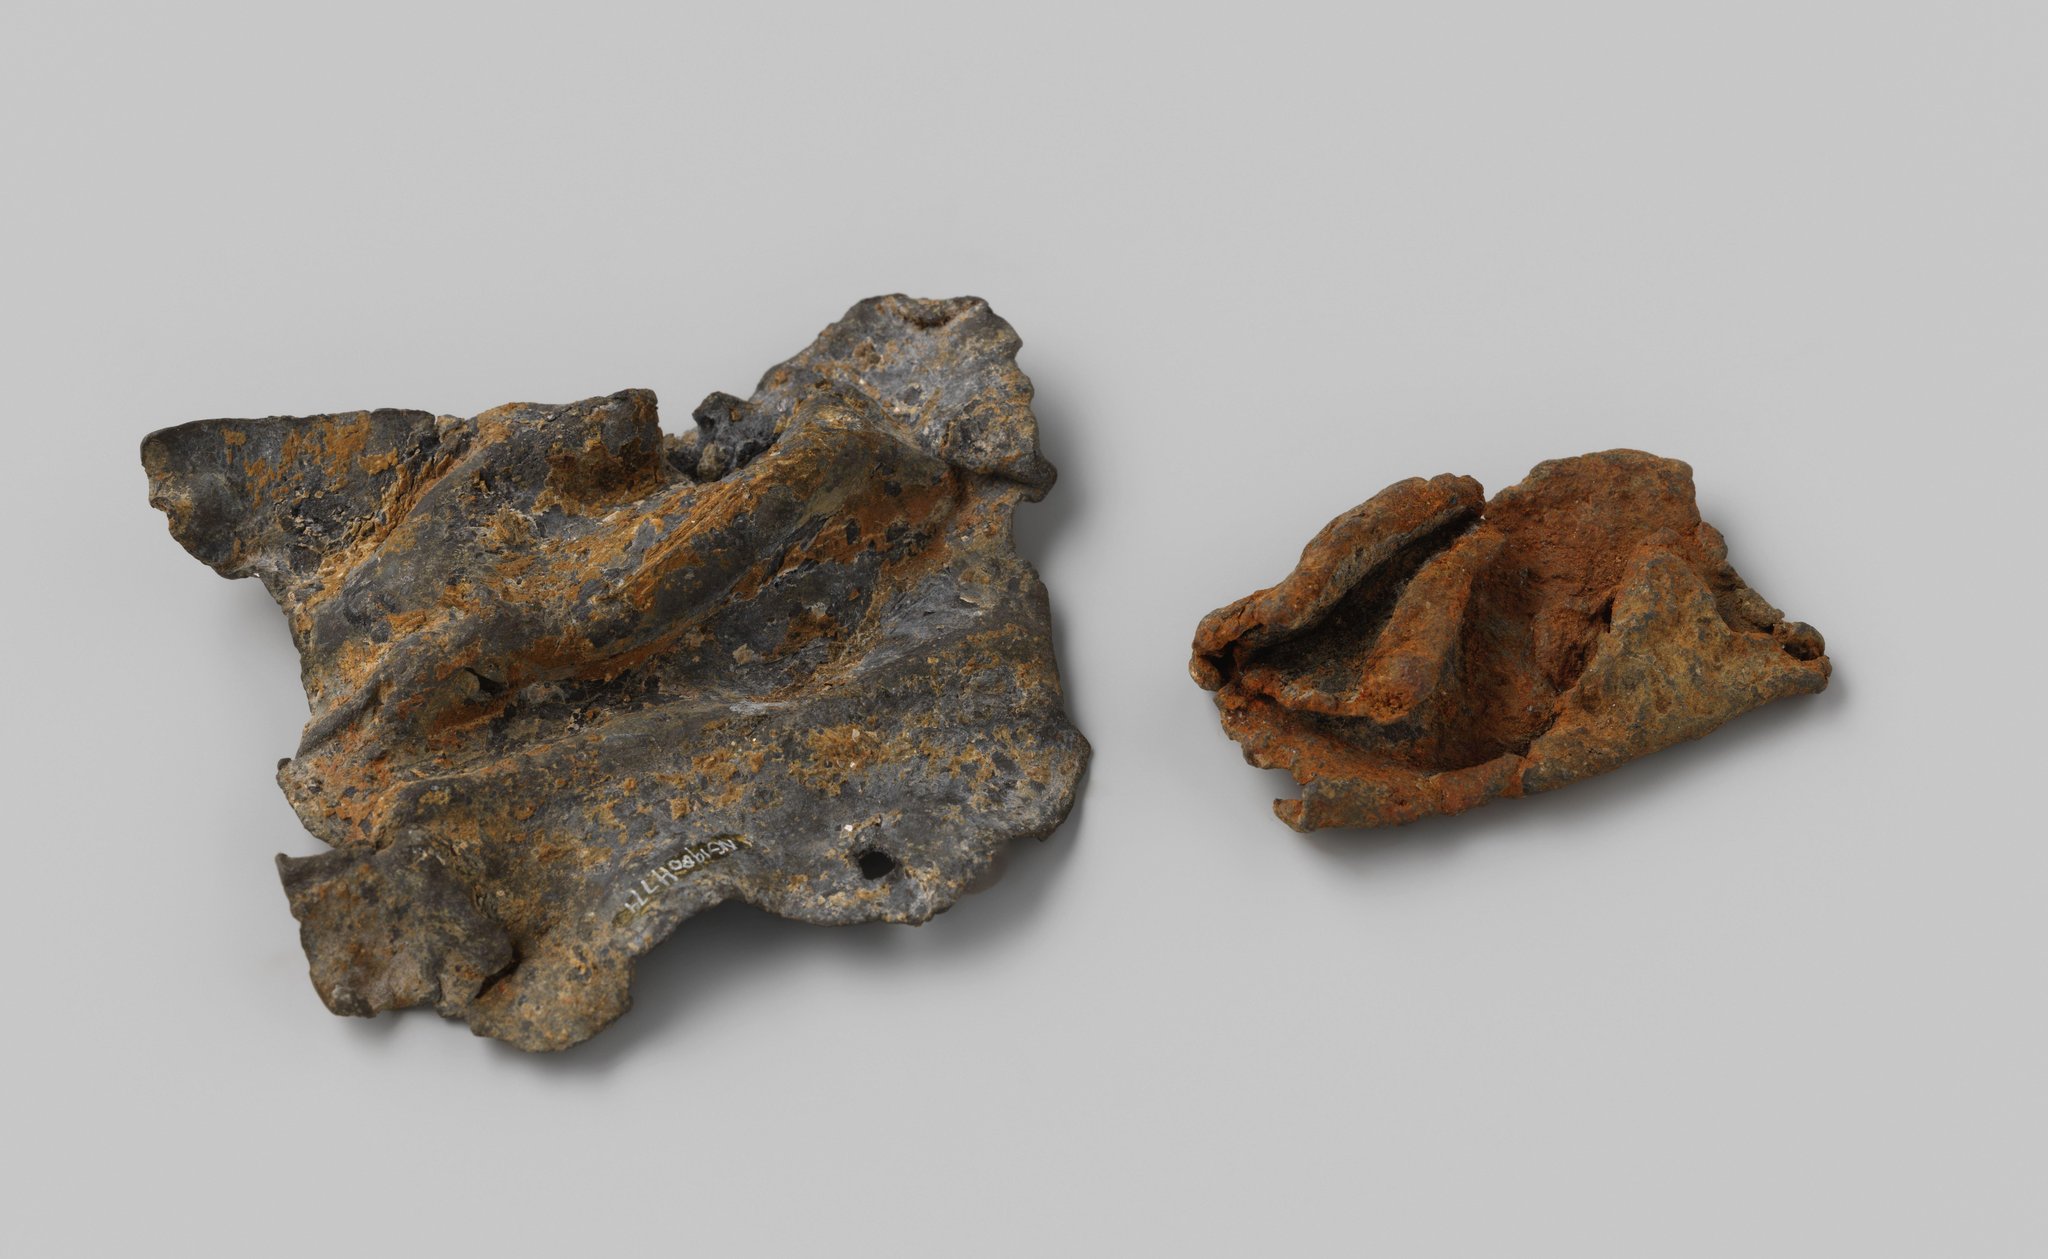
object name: fragment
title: Fragmenten van tin uit het wrak van de Oost-Indiëvaarder Hollandia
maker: Anonymous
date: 1700-1743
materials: tin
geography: netherlands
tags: verenigde oostindische compagnie, hollandia (schip), annet